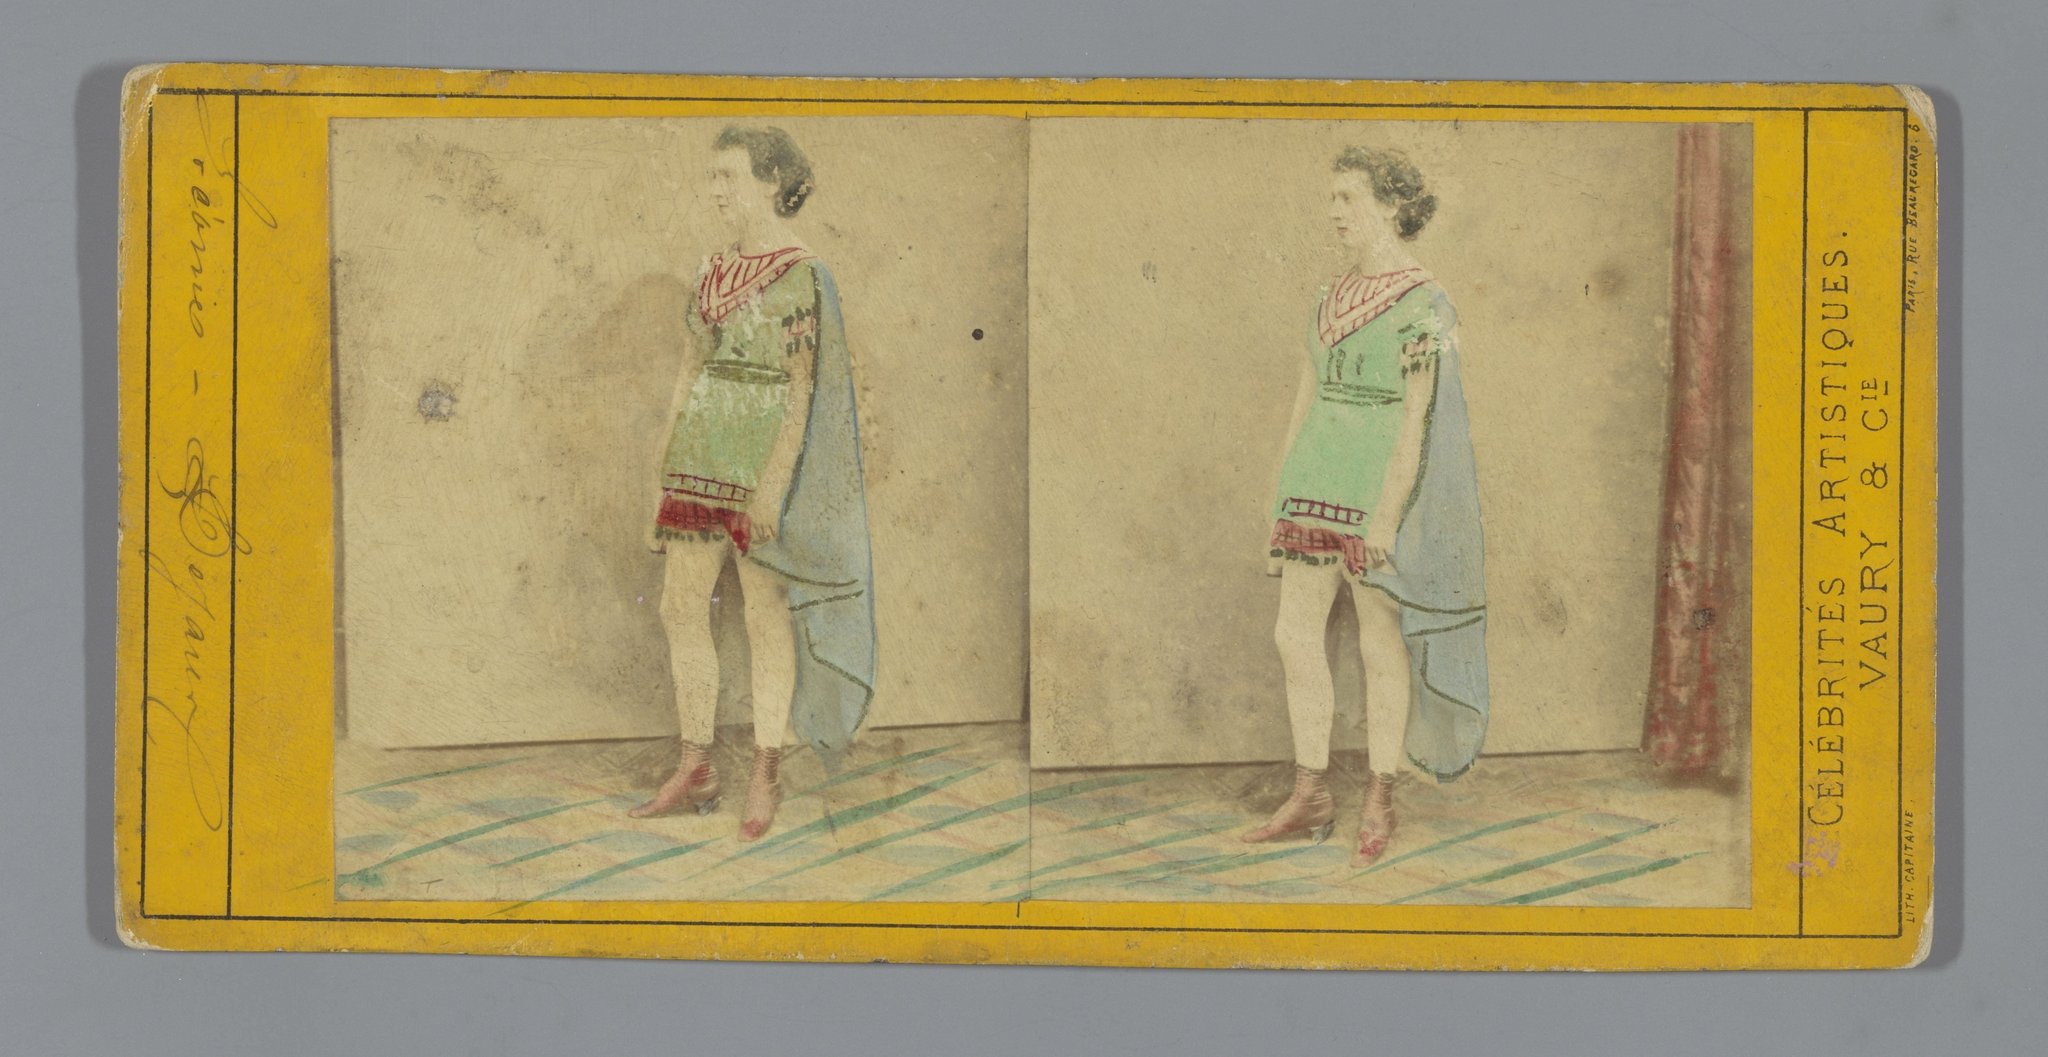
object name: stereograph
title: Léonie Degaux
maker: Anonymous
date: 1864-1895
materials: cardboard, paper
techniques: albumen print, hand coloring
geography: paris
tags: adult woman, anonymous historical person portrayed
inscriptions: title: ‘Léonie - Degaux’, number: ‘70’